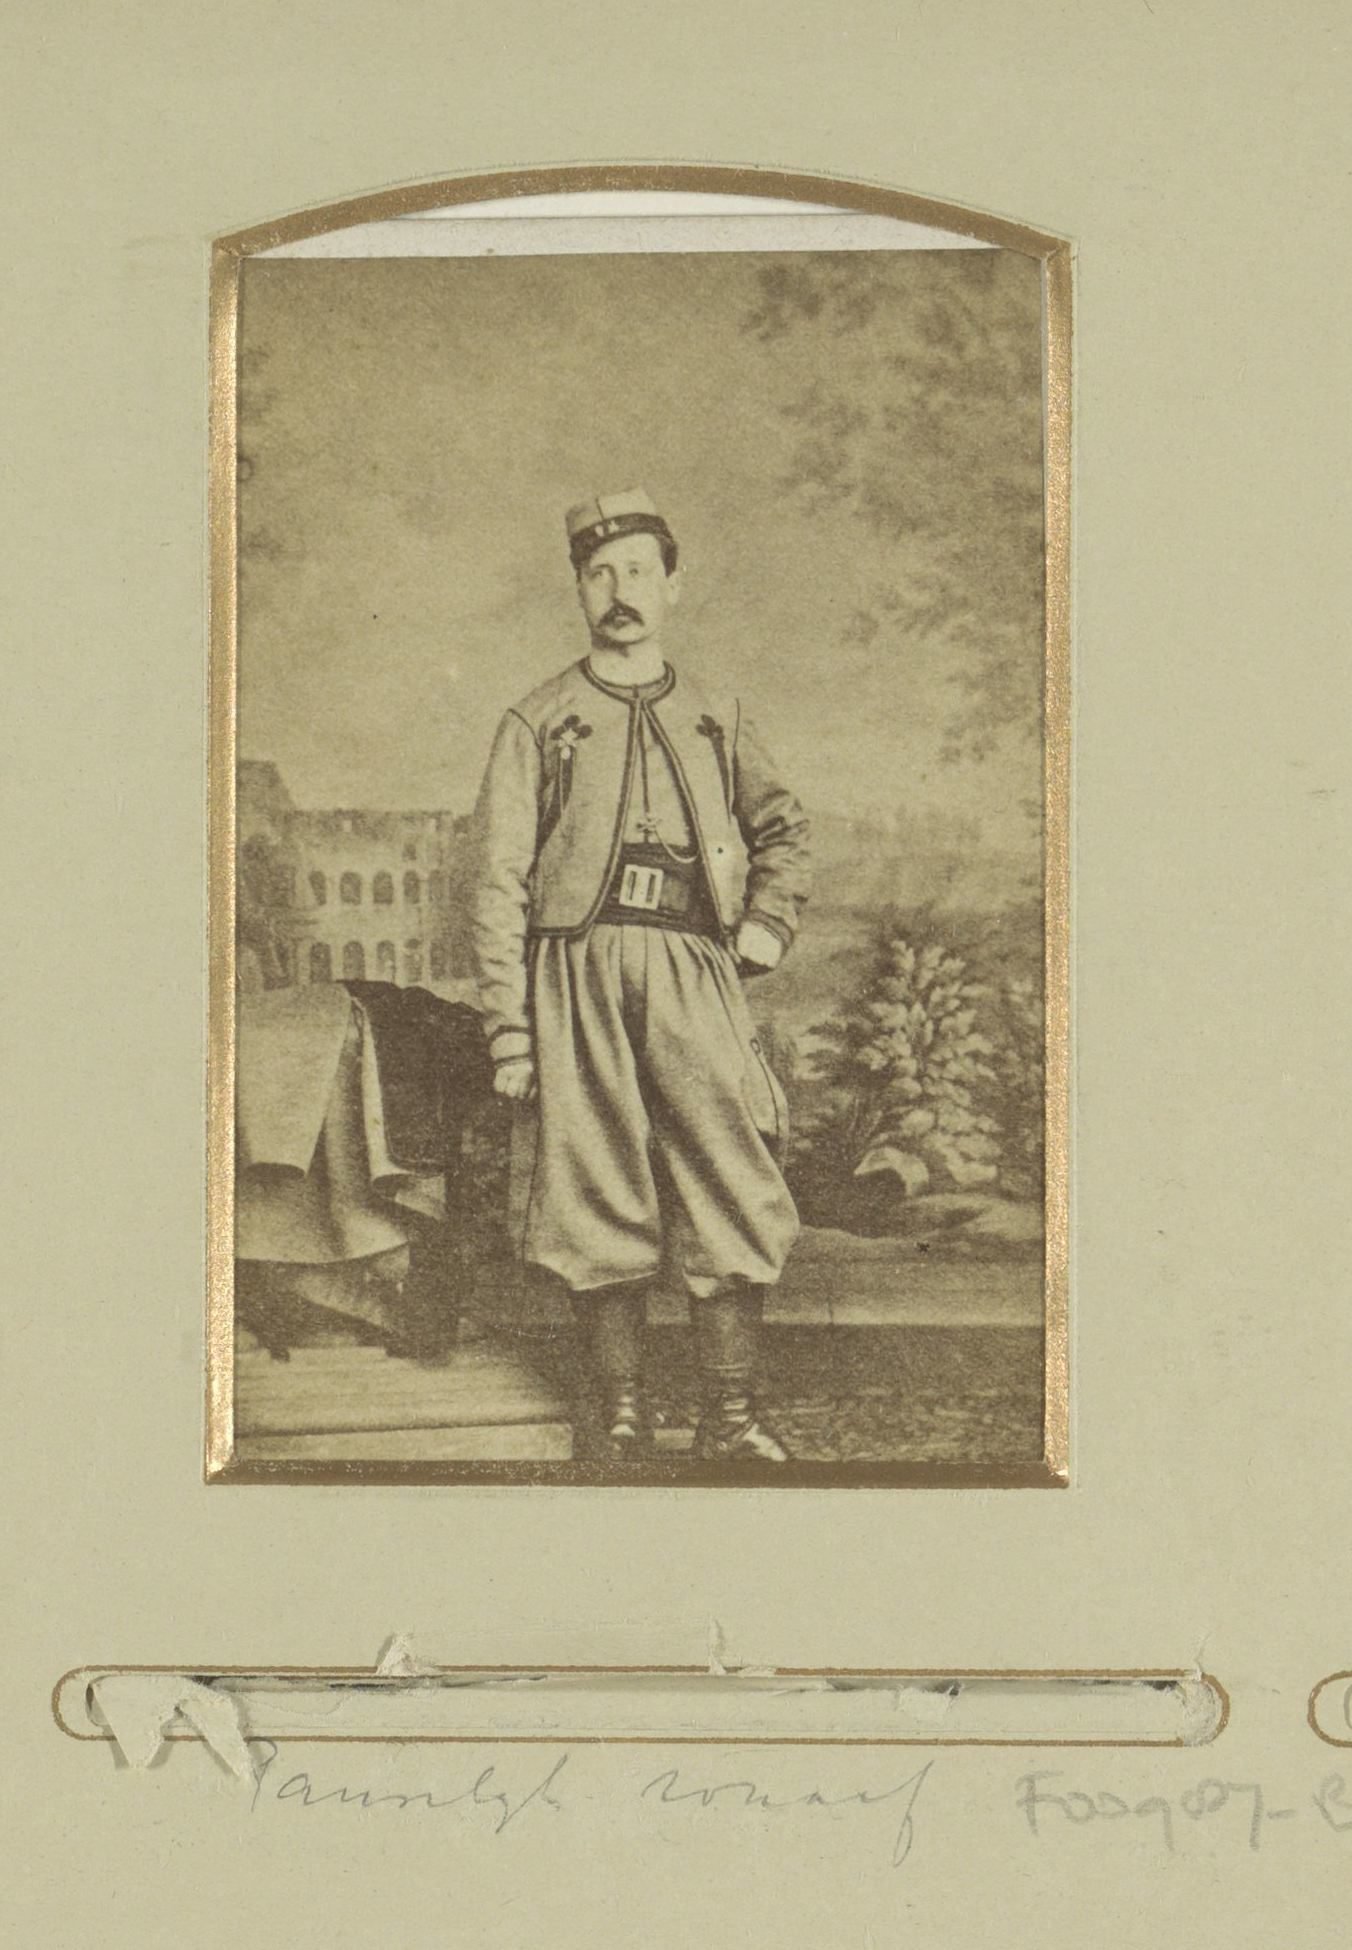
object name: photograph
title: Portret van een (vermoedelijk) Franse zoeaaf, staand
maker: Anonymous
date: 1860-1890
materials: cardboard, paper, photographic support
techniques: albumen print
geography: nantes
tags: studio requisites ~ photographer, warfare; military affairs, (military) uniforms, division of armed forces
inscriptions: inscription: ‘Librairie Catholique - A. Poirier-Legros rue d'Orléans, 8, Nantes.’, inscription: ‘de Ver[...]’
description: Onderdeel van Album met cartes-de-visite en kabinetfoto's van militairen in uniform.